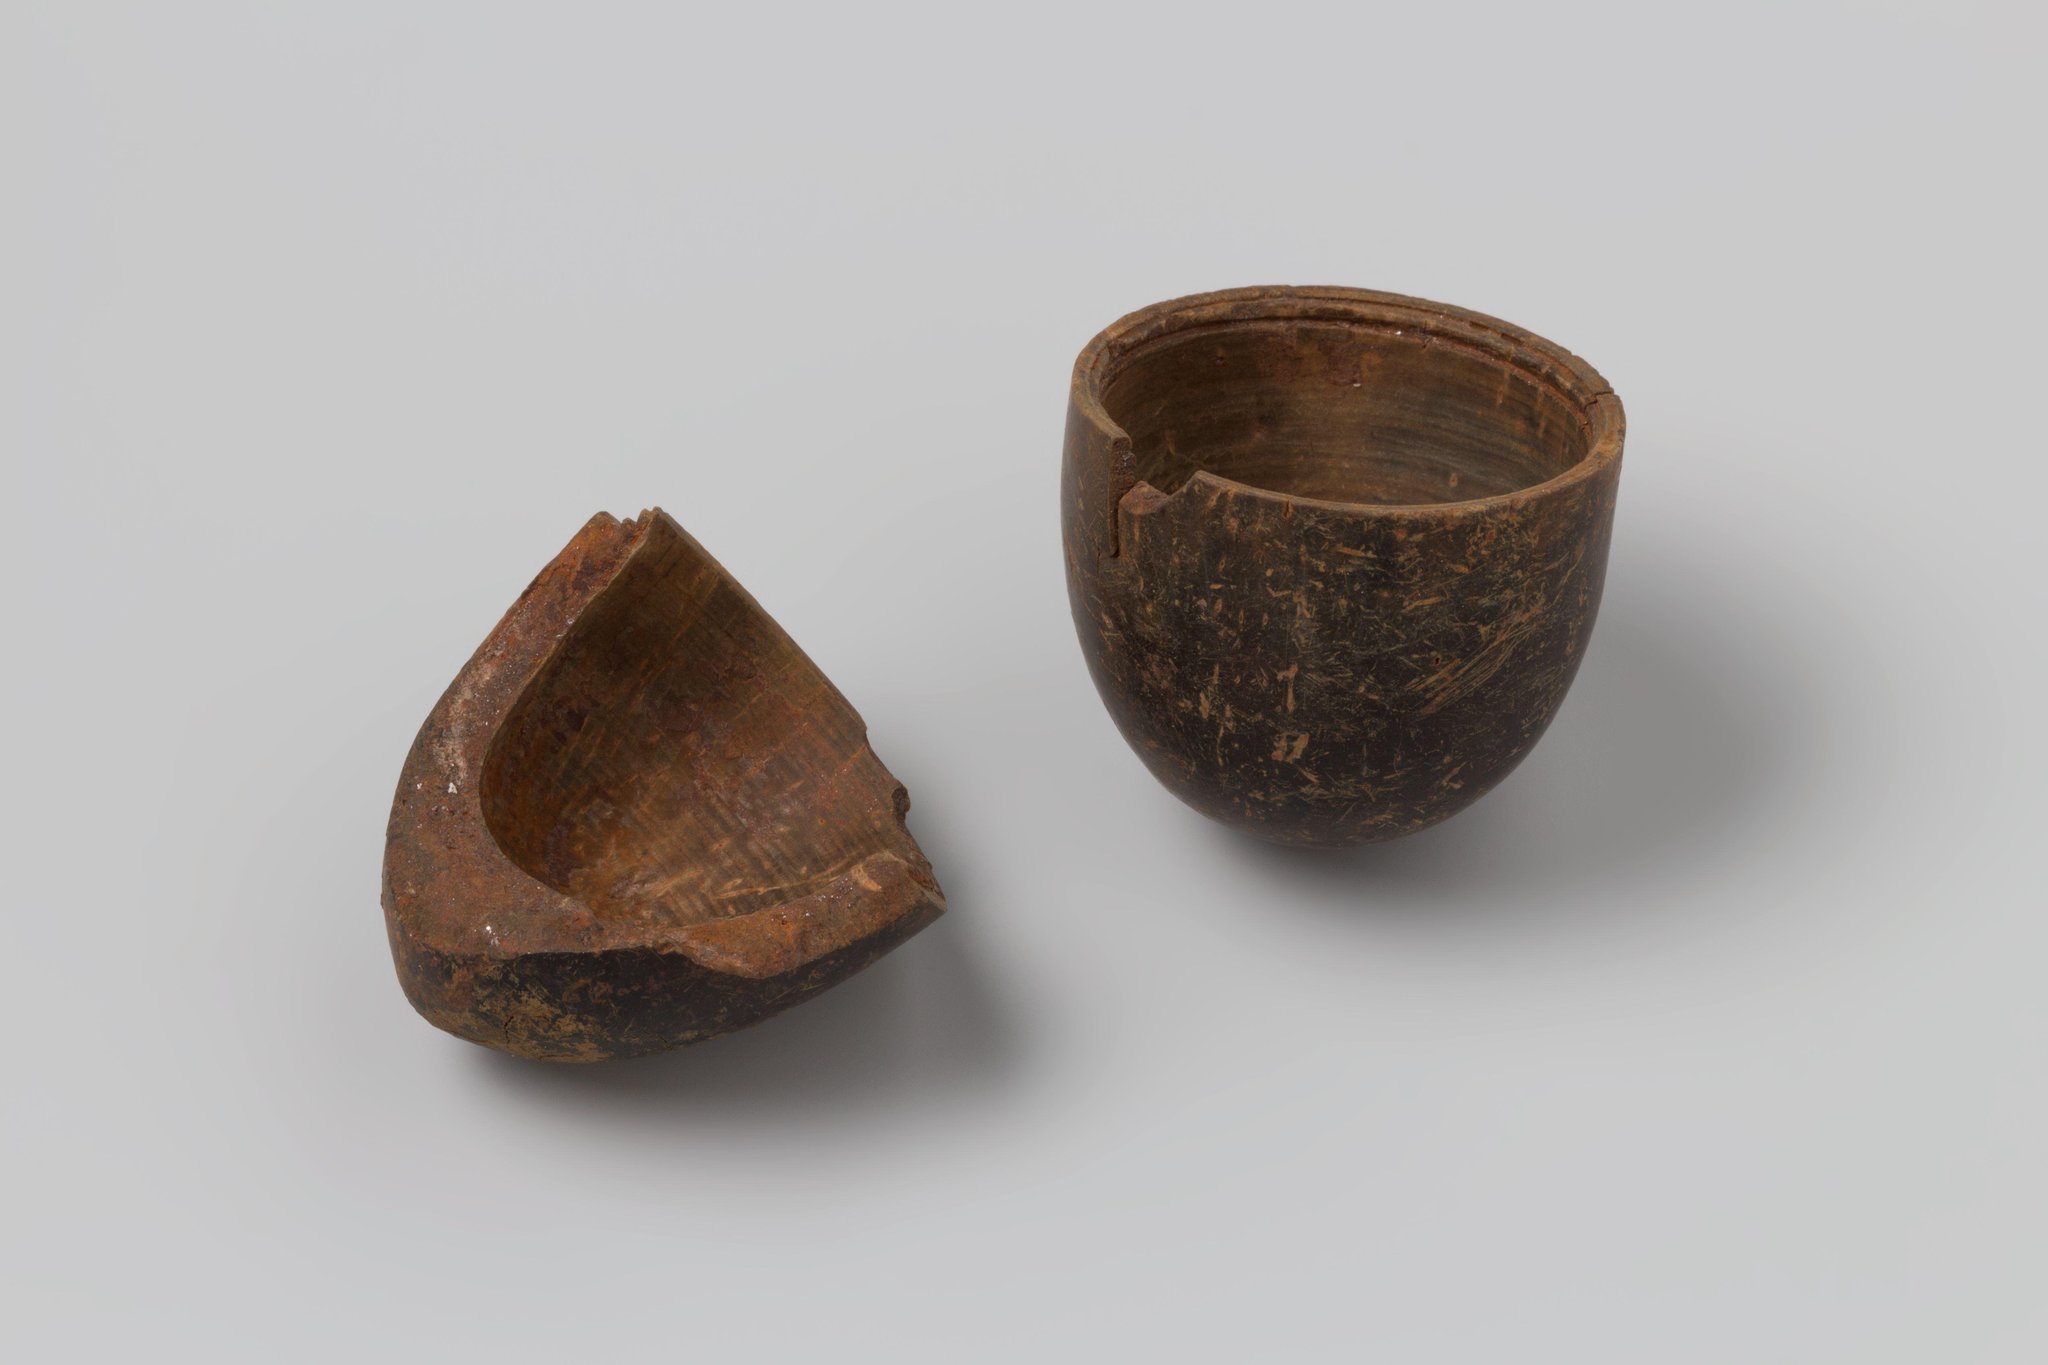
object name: pot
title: Fragmenten pot uit het wrak van de Oost-Indiëvaarder Hollandia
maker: Anonymous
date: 1700-1743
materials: bone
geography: netherlands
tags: verenigde oostindische compagnie, hollandia (schip), annet